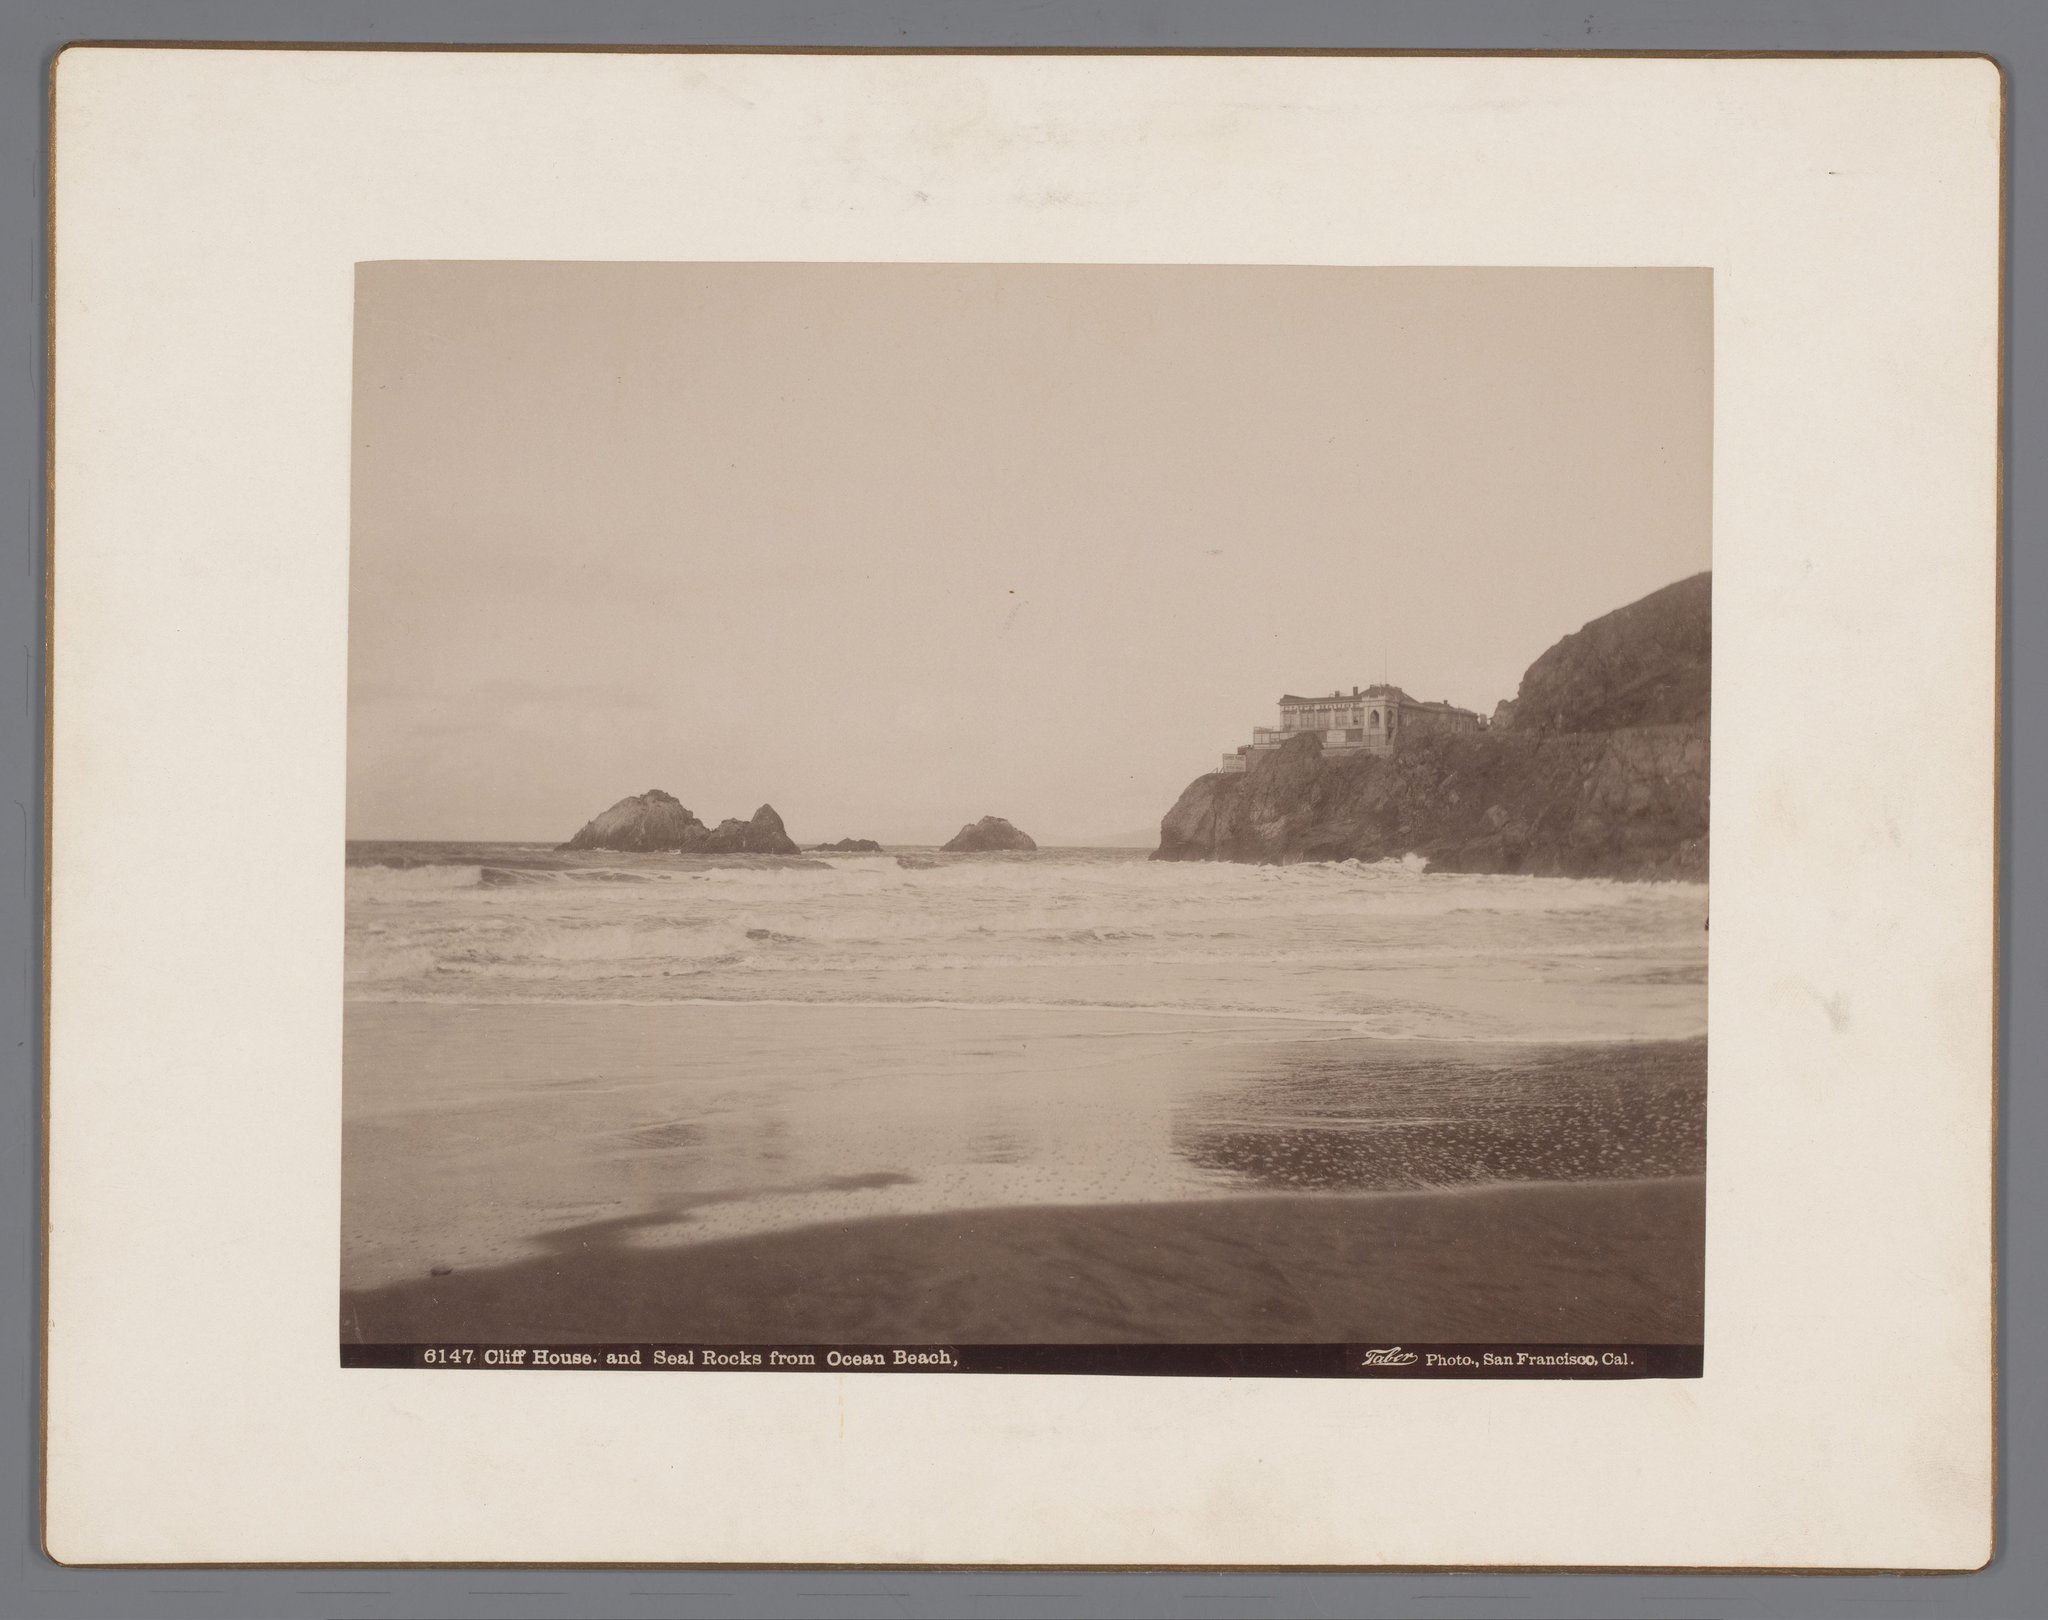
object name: photograph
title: Huis op rots, Ocean Beach, California, Verenigde Staten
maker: isaiah west taber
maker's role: fotograaf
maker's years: 1830-1912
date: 1881-1910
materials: cardboard, paper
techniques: albumen print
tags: californië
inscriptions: inscription: ‘6147 Cliff House. and Seal Rocks from Ocean Beach, Faber Photo, San Francisco, Cal.’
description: Huis op rots, Ocean Beach, California, Verenigde Staten.